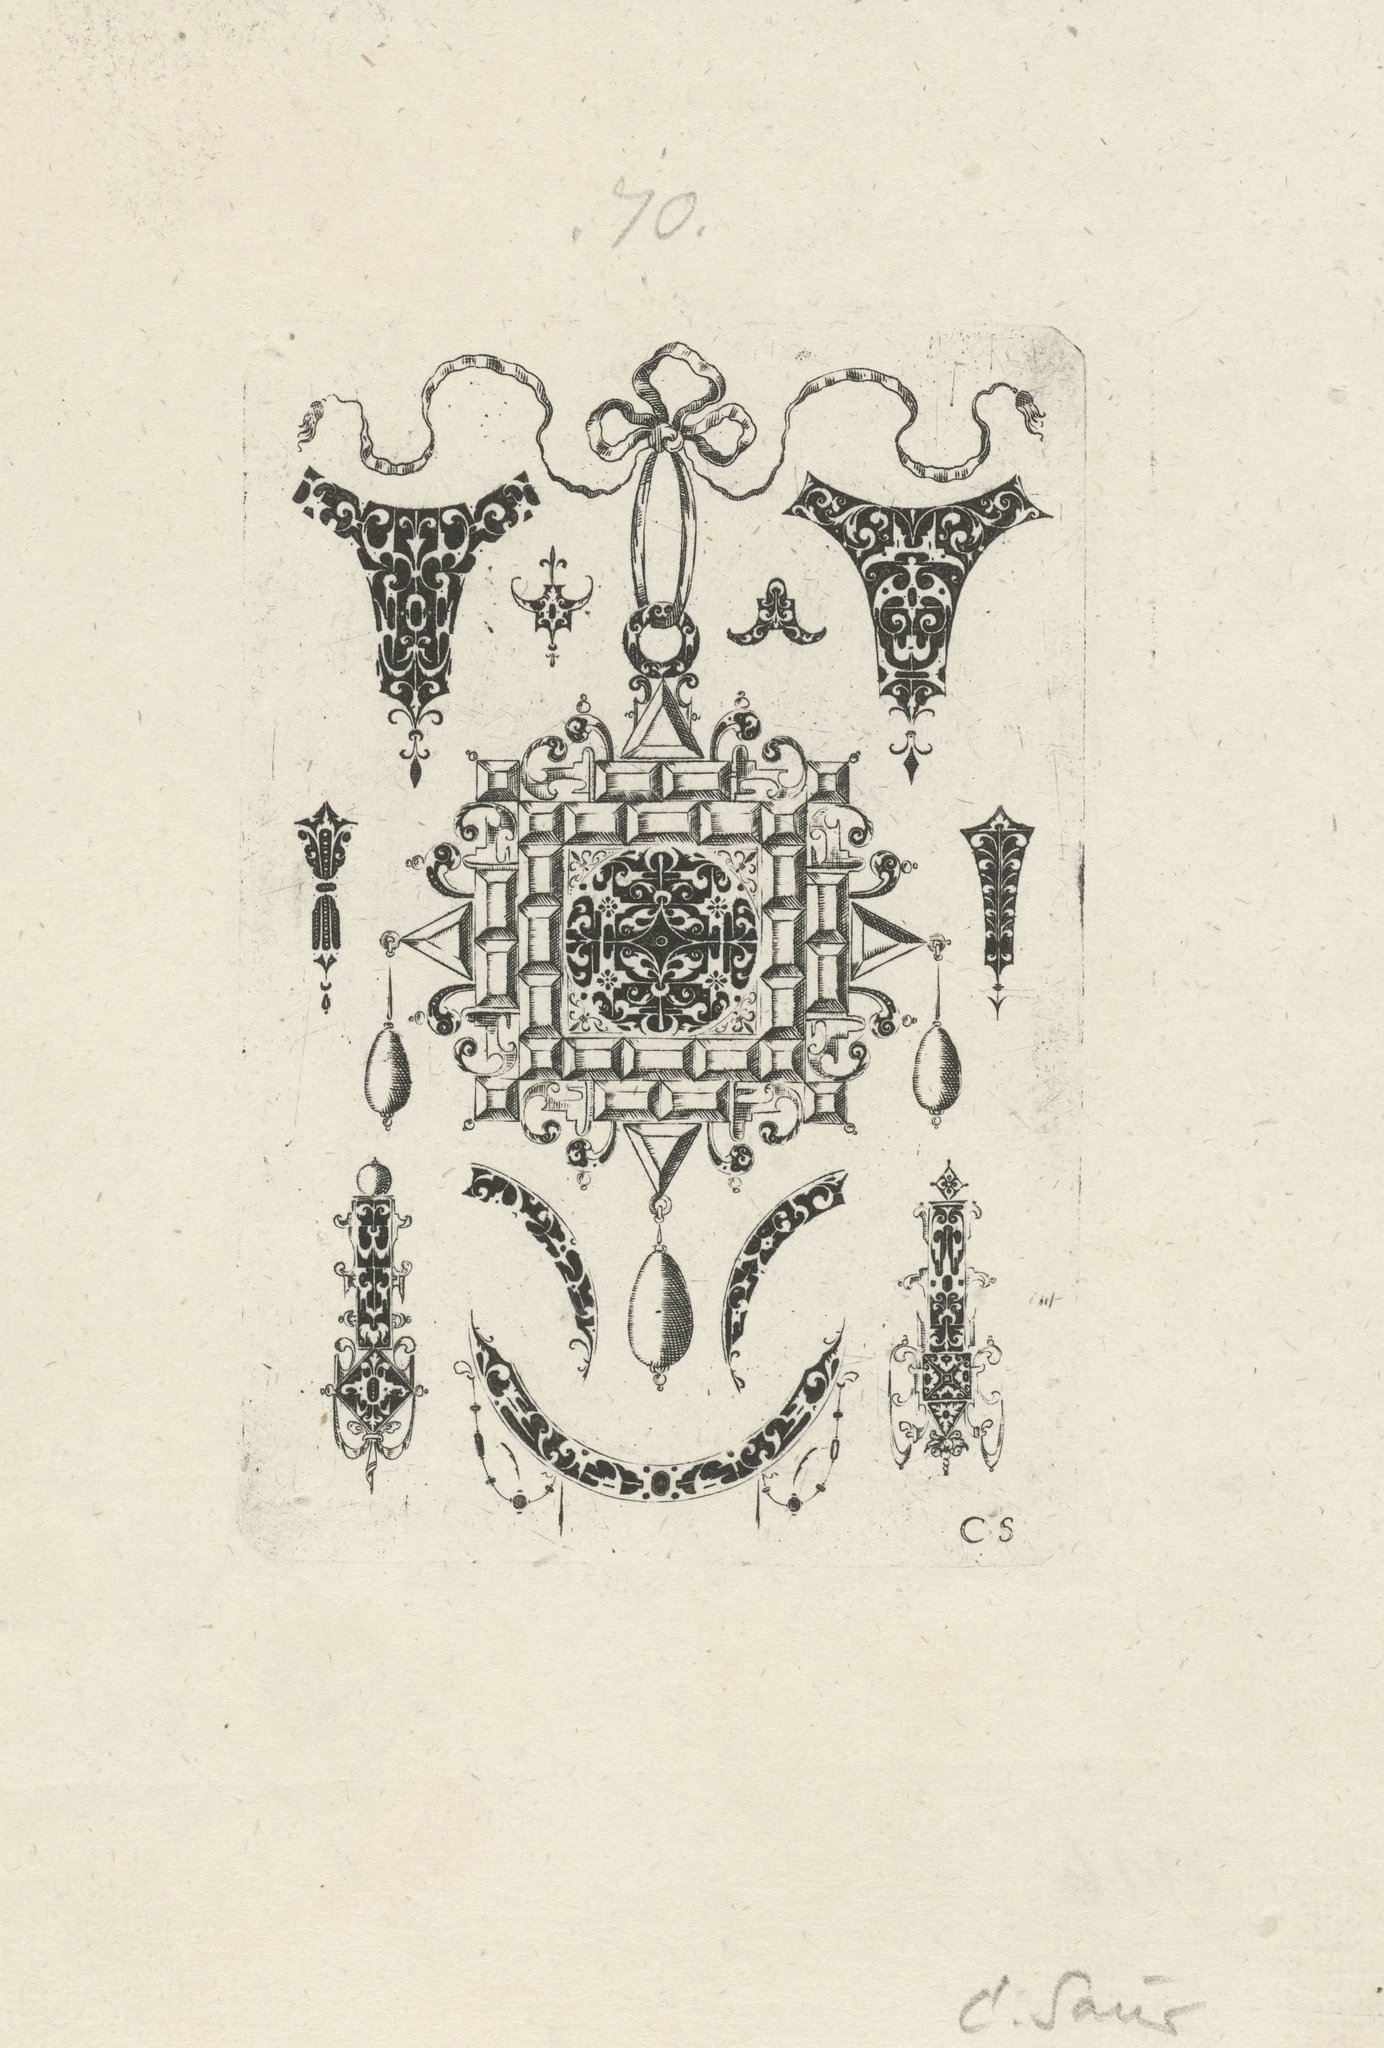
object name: ornament print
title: Reeks van zes ontwerpen voor juwelen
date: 1575-1635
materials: paper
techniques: engraving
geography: germany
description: Medaillon gedecoreerd met wit krulwerk op een zwart fond, in een met stenen ingelegd vierkant. Om de hanger heen bevinden zich elf kostuumornamenten. Uit serie Hic liber aurifecibus valde utilis..., bestaande uit een titelblad en 5 bladen.